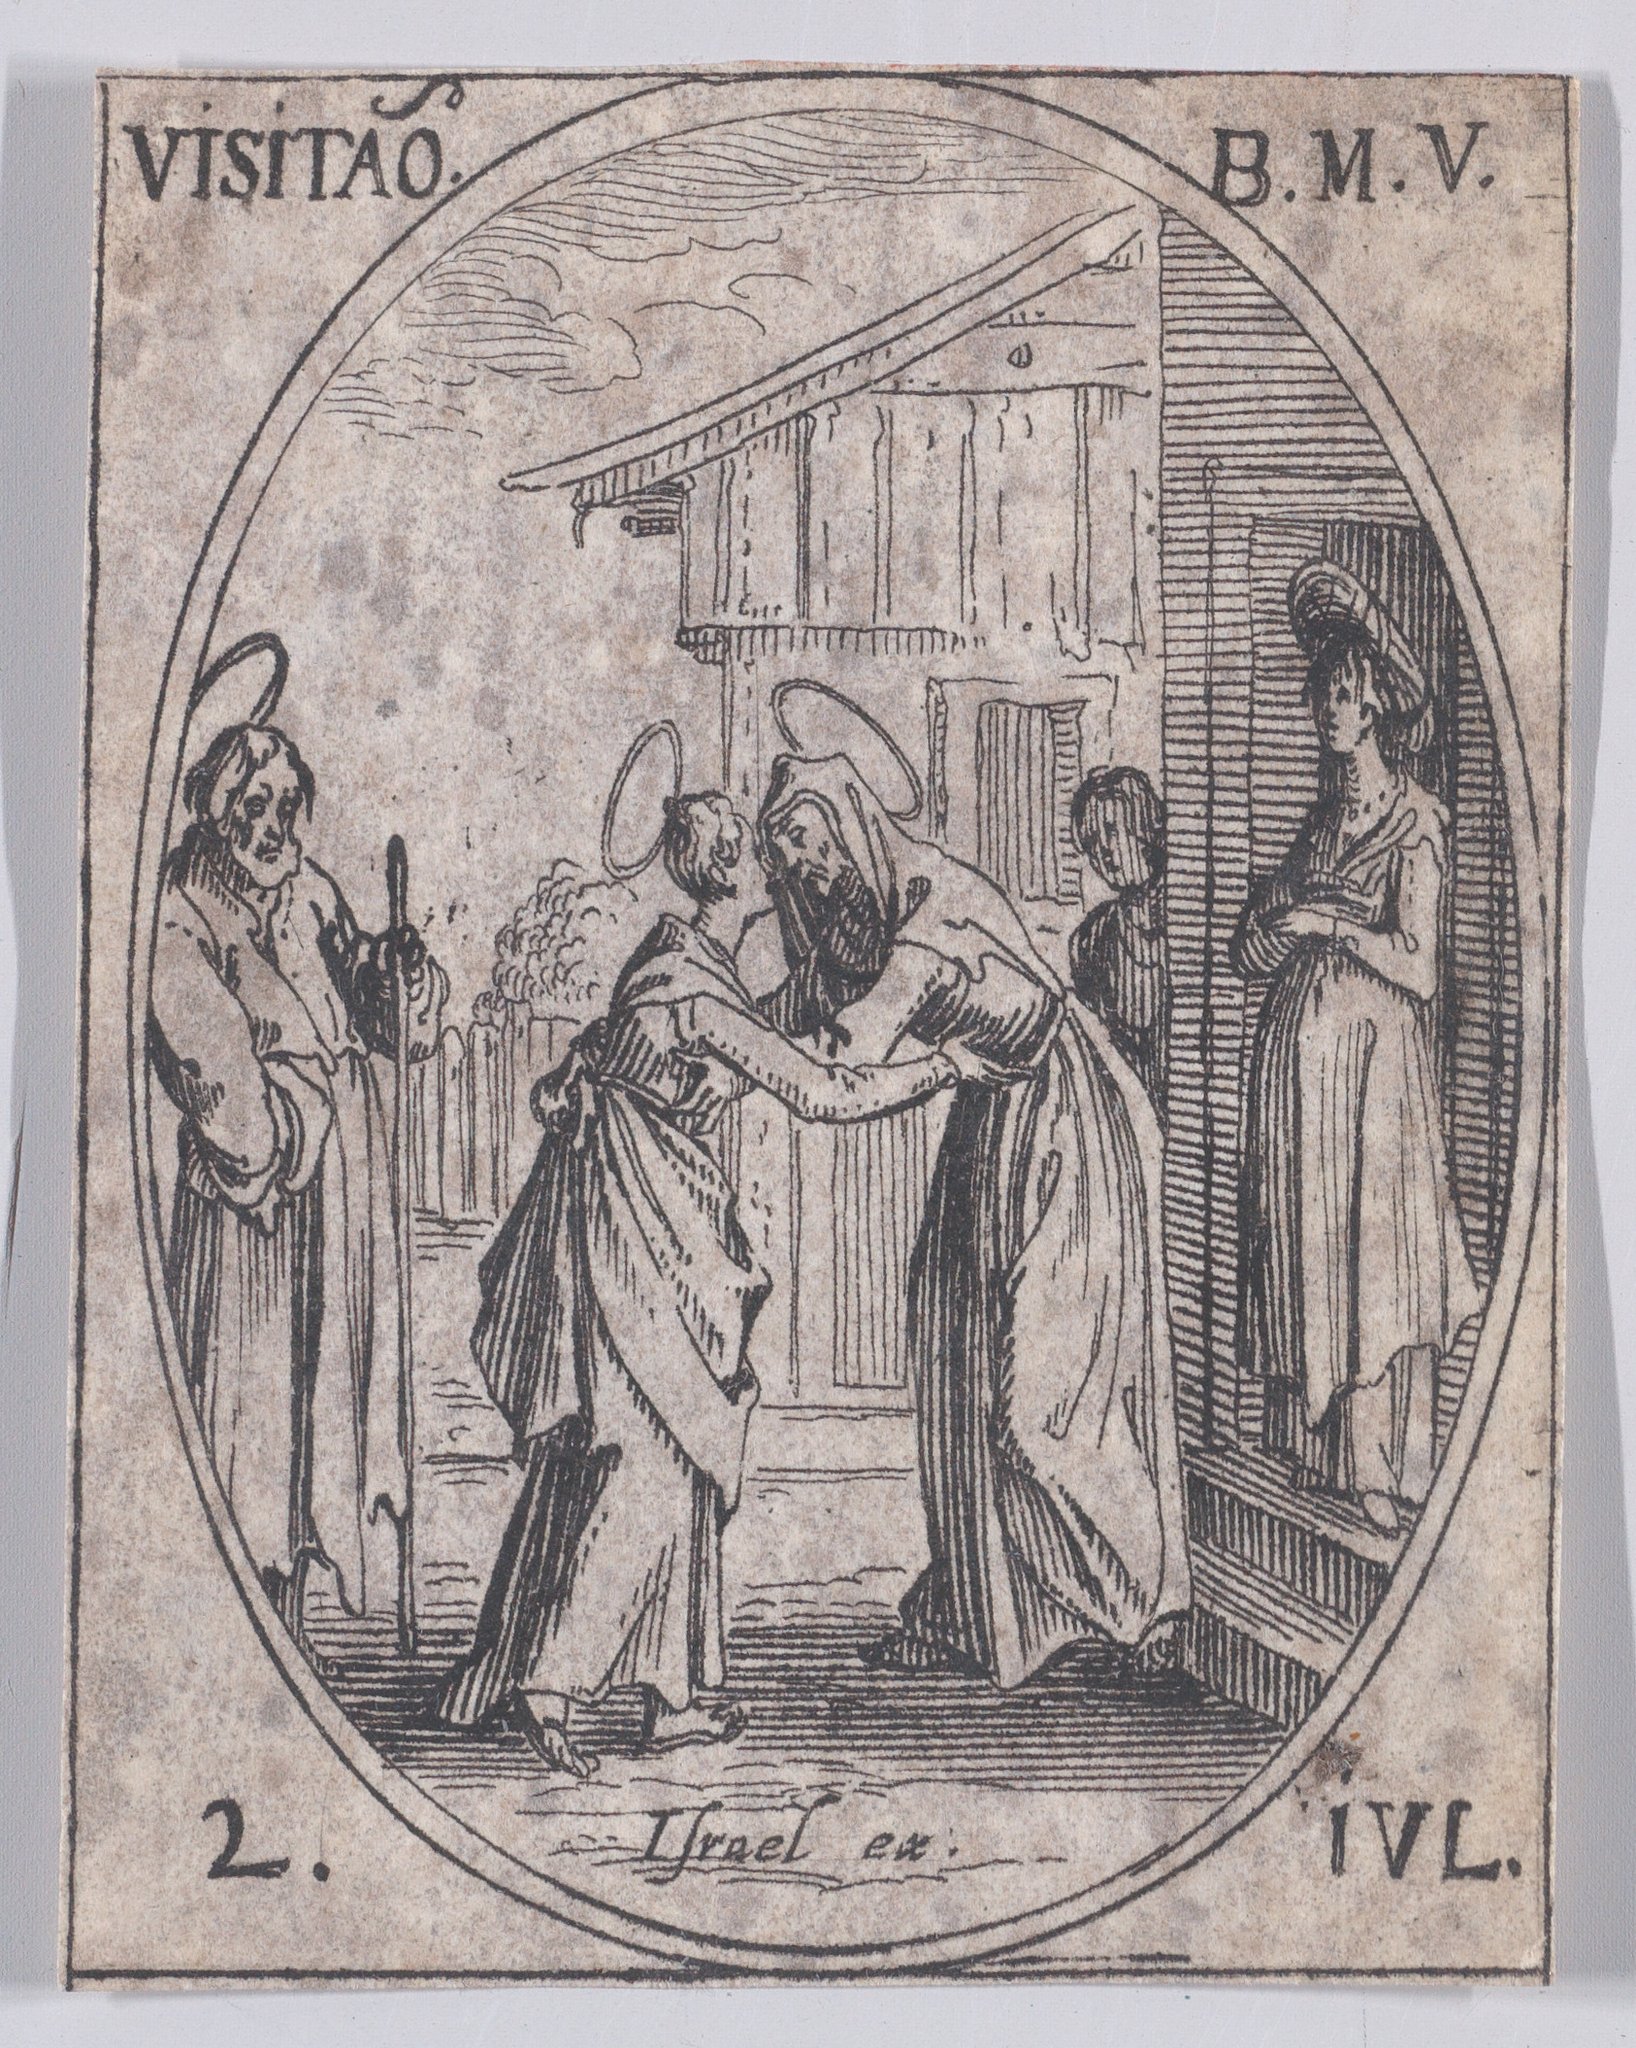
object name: print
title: La Visitation de la Sainte Vierge (The Visitation), July 2nd, from "Les Images De Tous Les Saincts et Saintes de L'Année" (Images of All of the Saints and Religious Events of the Year)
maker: jacques callot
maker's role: artist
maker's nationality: french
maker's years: 1592-1635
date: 1636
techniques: etching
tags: virgin mary,visitation